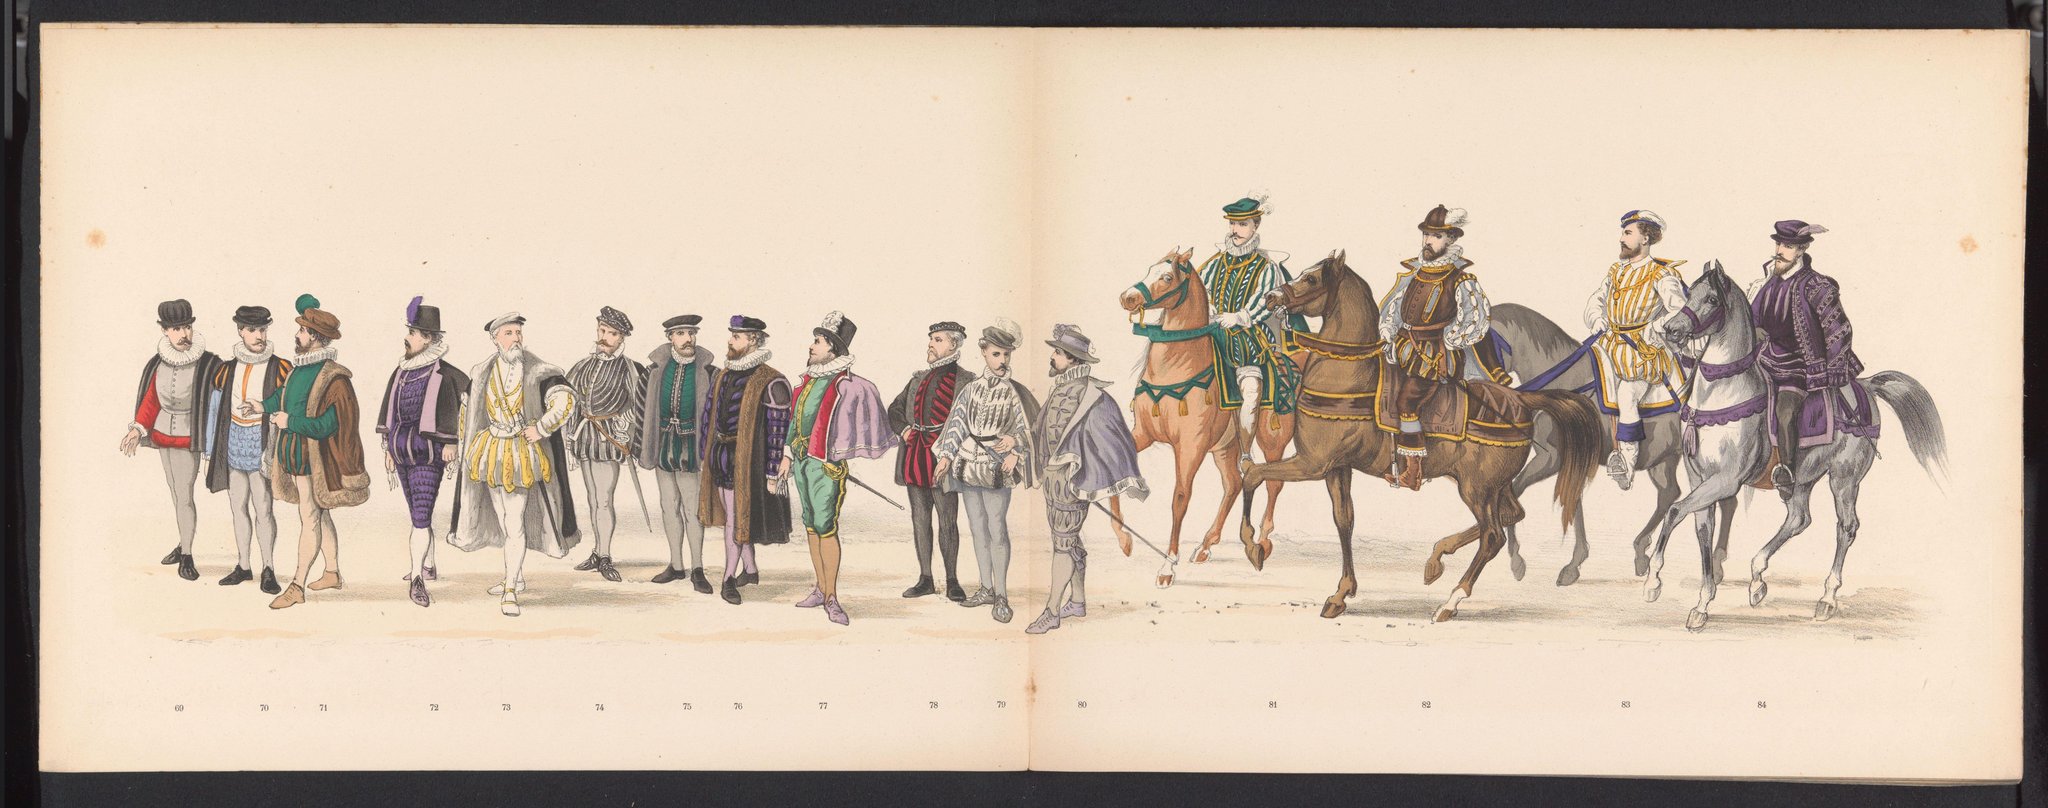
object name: print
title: Maskerade gehouden door de leden van het Leidsche studentencorps den 15den Juni 1875 ter viering van den 300sten verjaardag der Leidsche Hoogeschool, voorstellende de Leidsche Hoogeschool, afgebeeld in de beroemdste en merkwaardigste mannen, die van hare stichting af hun naam aan den haren hebben verbonden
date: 1875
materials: paper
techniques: hand coloring, lithograph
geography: netherlands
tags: students' pageant, costumes used in pageants, leiden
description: Historische gekostumeerde optocht van de studenten van de Leidse Hogeschool gehouden op 15 juni 1875 ter gelegenheid van het 300-jarig bestaan van de Hogeschool. De optocht verbeeldt de beroemdste mannen verbonden aan de Hogeschool. Vierde plaat met de groepen genummerd 69-84. Onderdeel van de serie van 21 aaneen geplakte bladen.